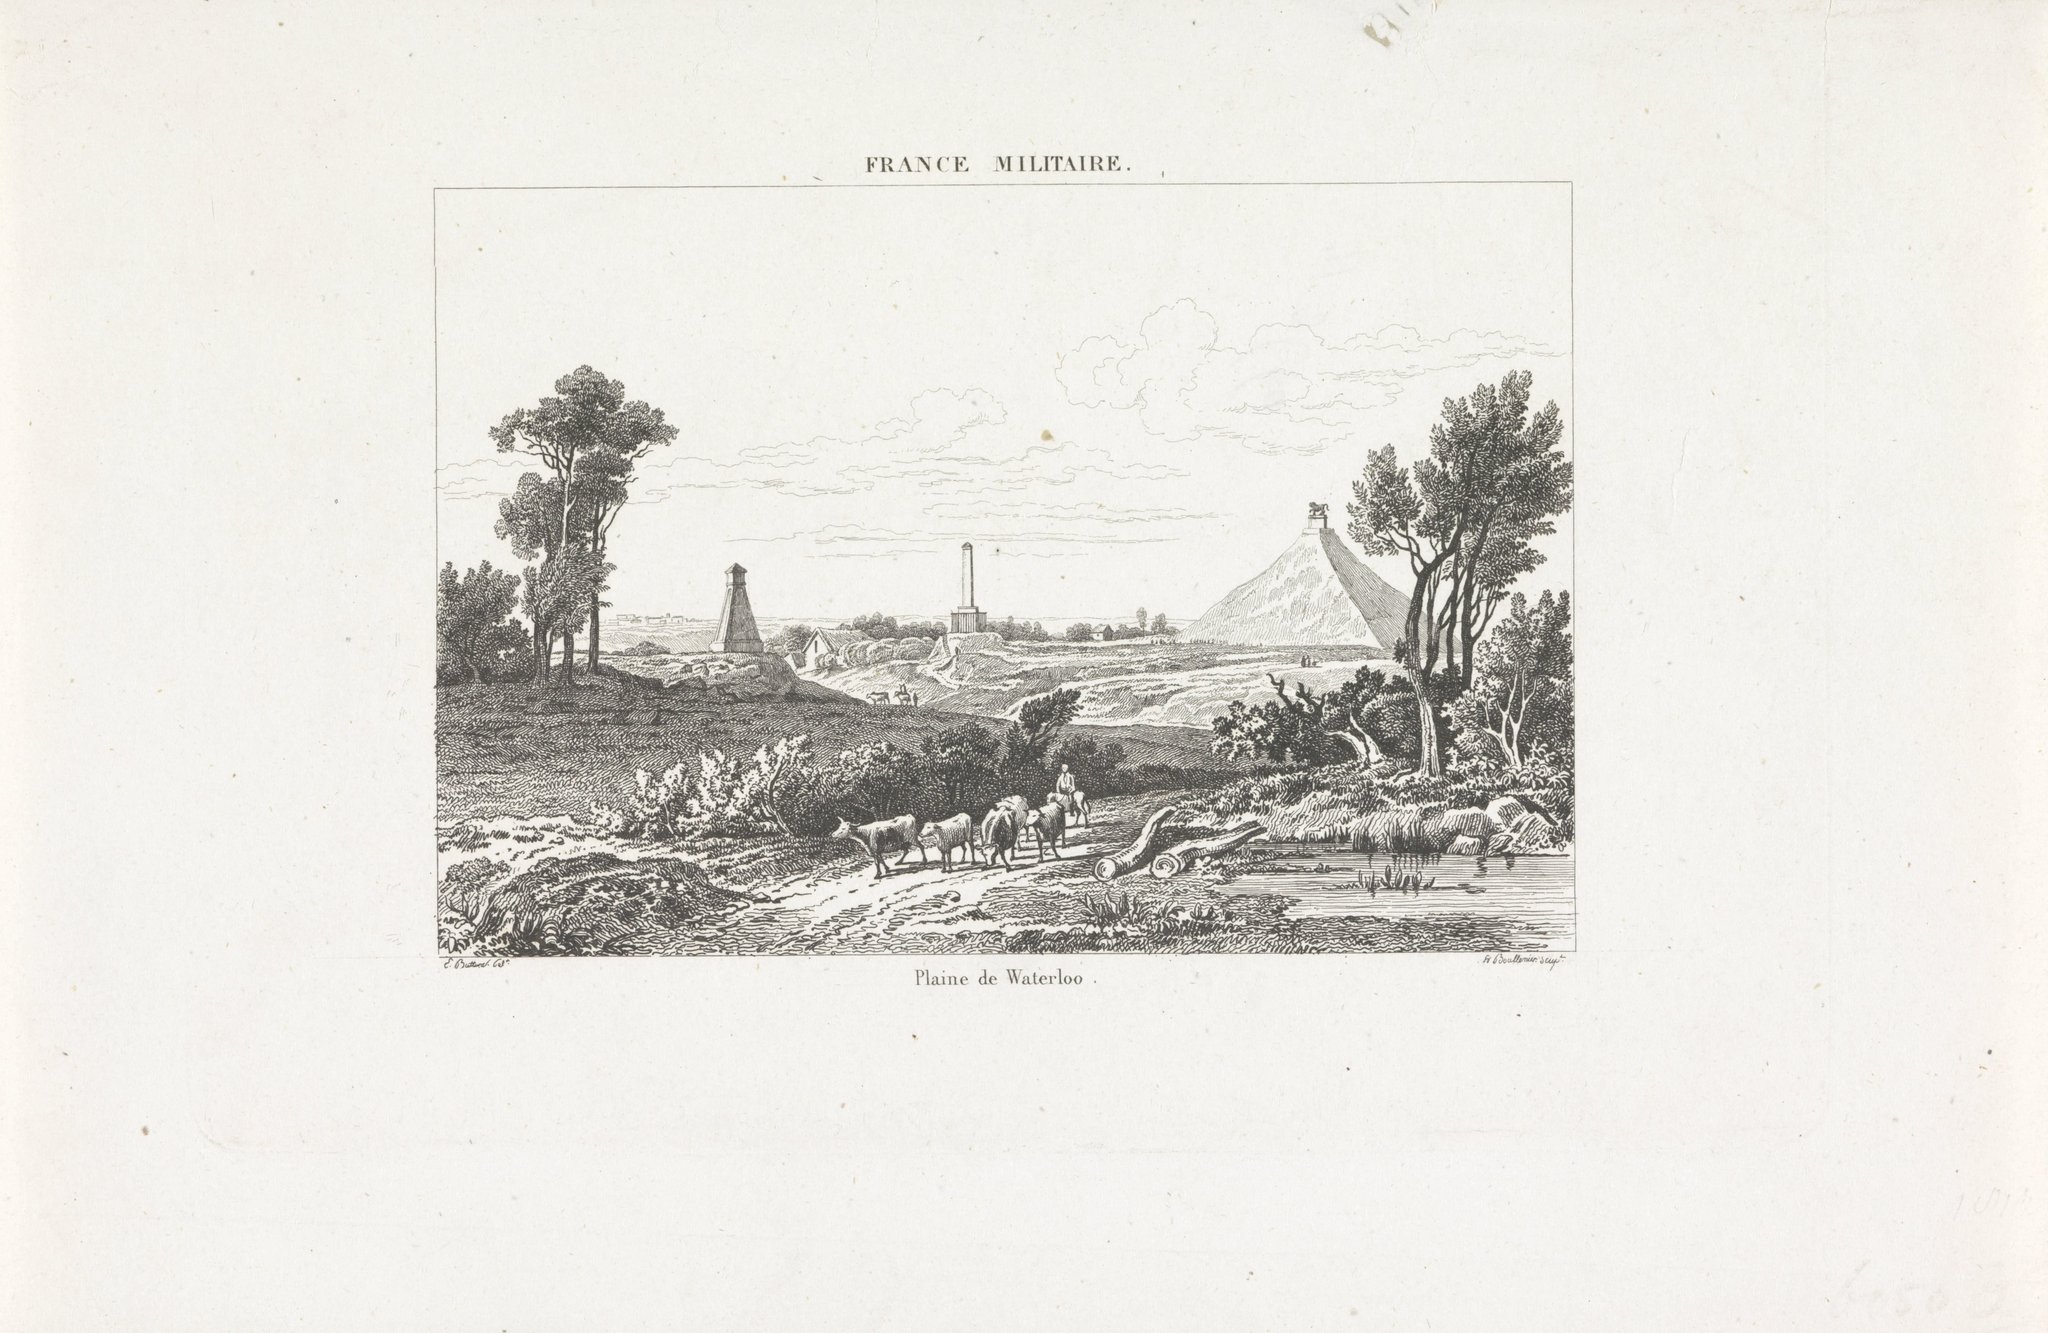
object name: print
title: France Militaire / Plaine de Waterloo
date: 1825-1852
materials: paper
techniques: etching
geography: france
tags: landscape with monument, waterloo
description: Gezicht op het slagveld van Waterloo met de verschillende monumenten. Op de voorgrond een veehoeder met koeien op de weg.